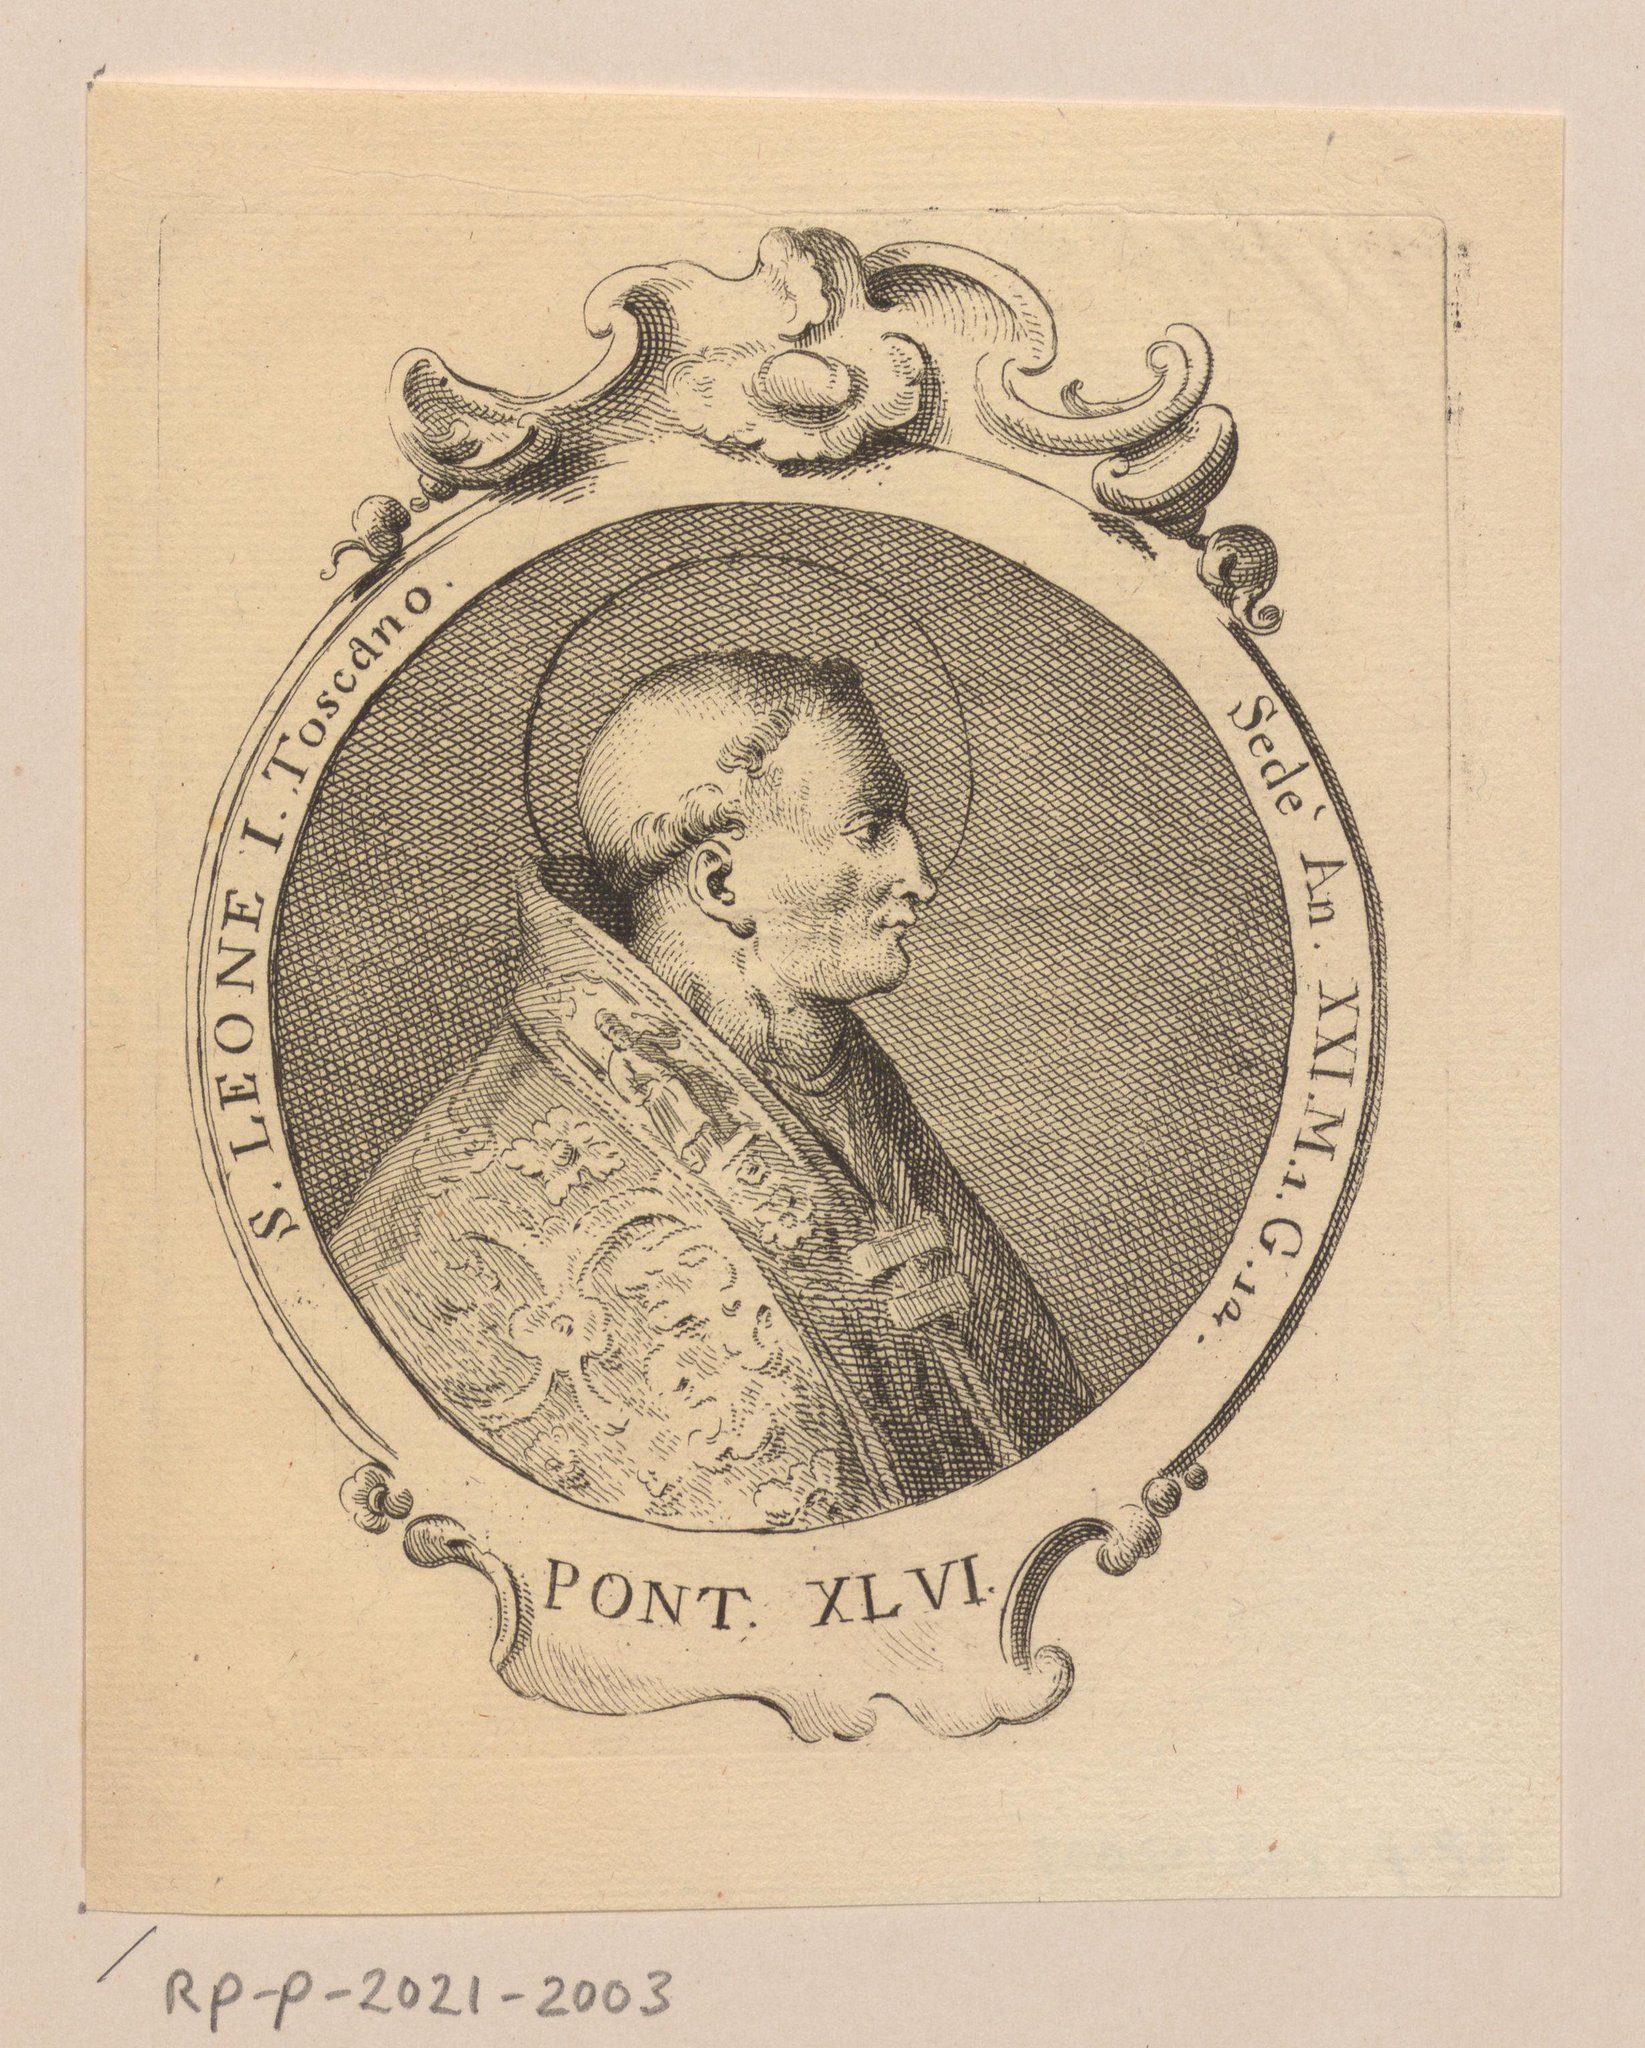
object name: print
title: Portret van paus Leo I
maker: Anonymous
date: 1775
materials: paper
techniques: etching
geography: italy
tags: rome, rocaille ornament, historical persons, pope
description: Prent waarschijnlijk uit: Effigies Romanorum pontificum a S. Petro ad Pium VI (...). 2 dln. Venetië en Bassano del Grappa: Giuseppe Remondini, 1775. Prent met tekst in boekdruk op verso eerder gebruikt in: Platina (Bartholomaeus Sacchi). Storia delle vite dei pontefici da Platina e d'altri autori (...). 5 dln. Venetië: Domenico Ferrarin, 1760, dl. 1.